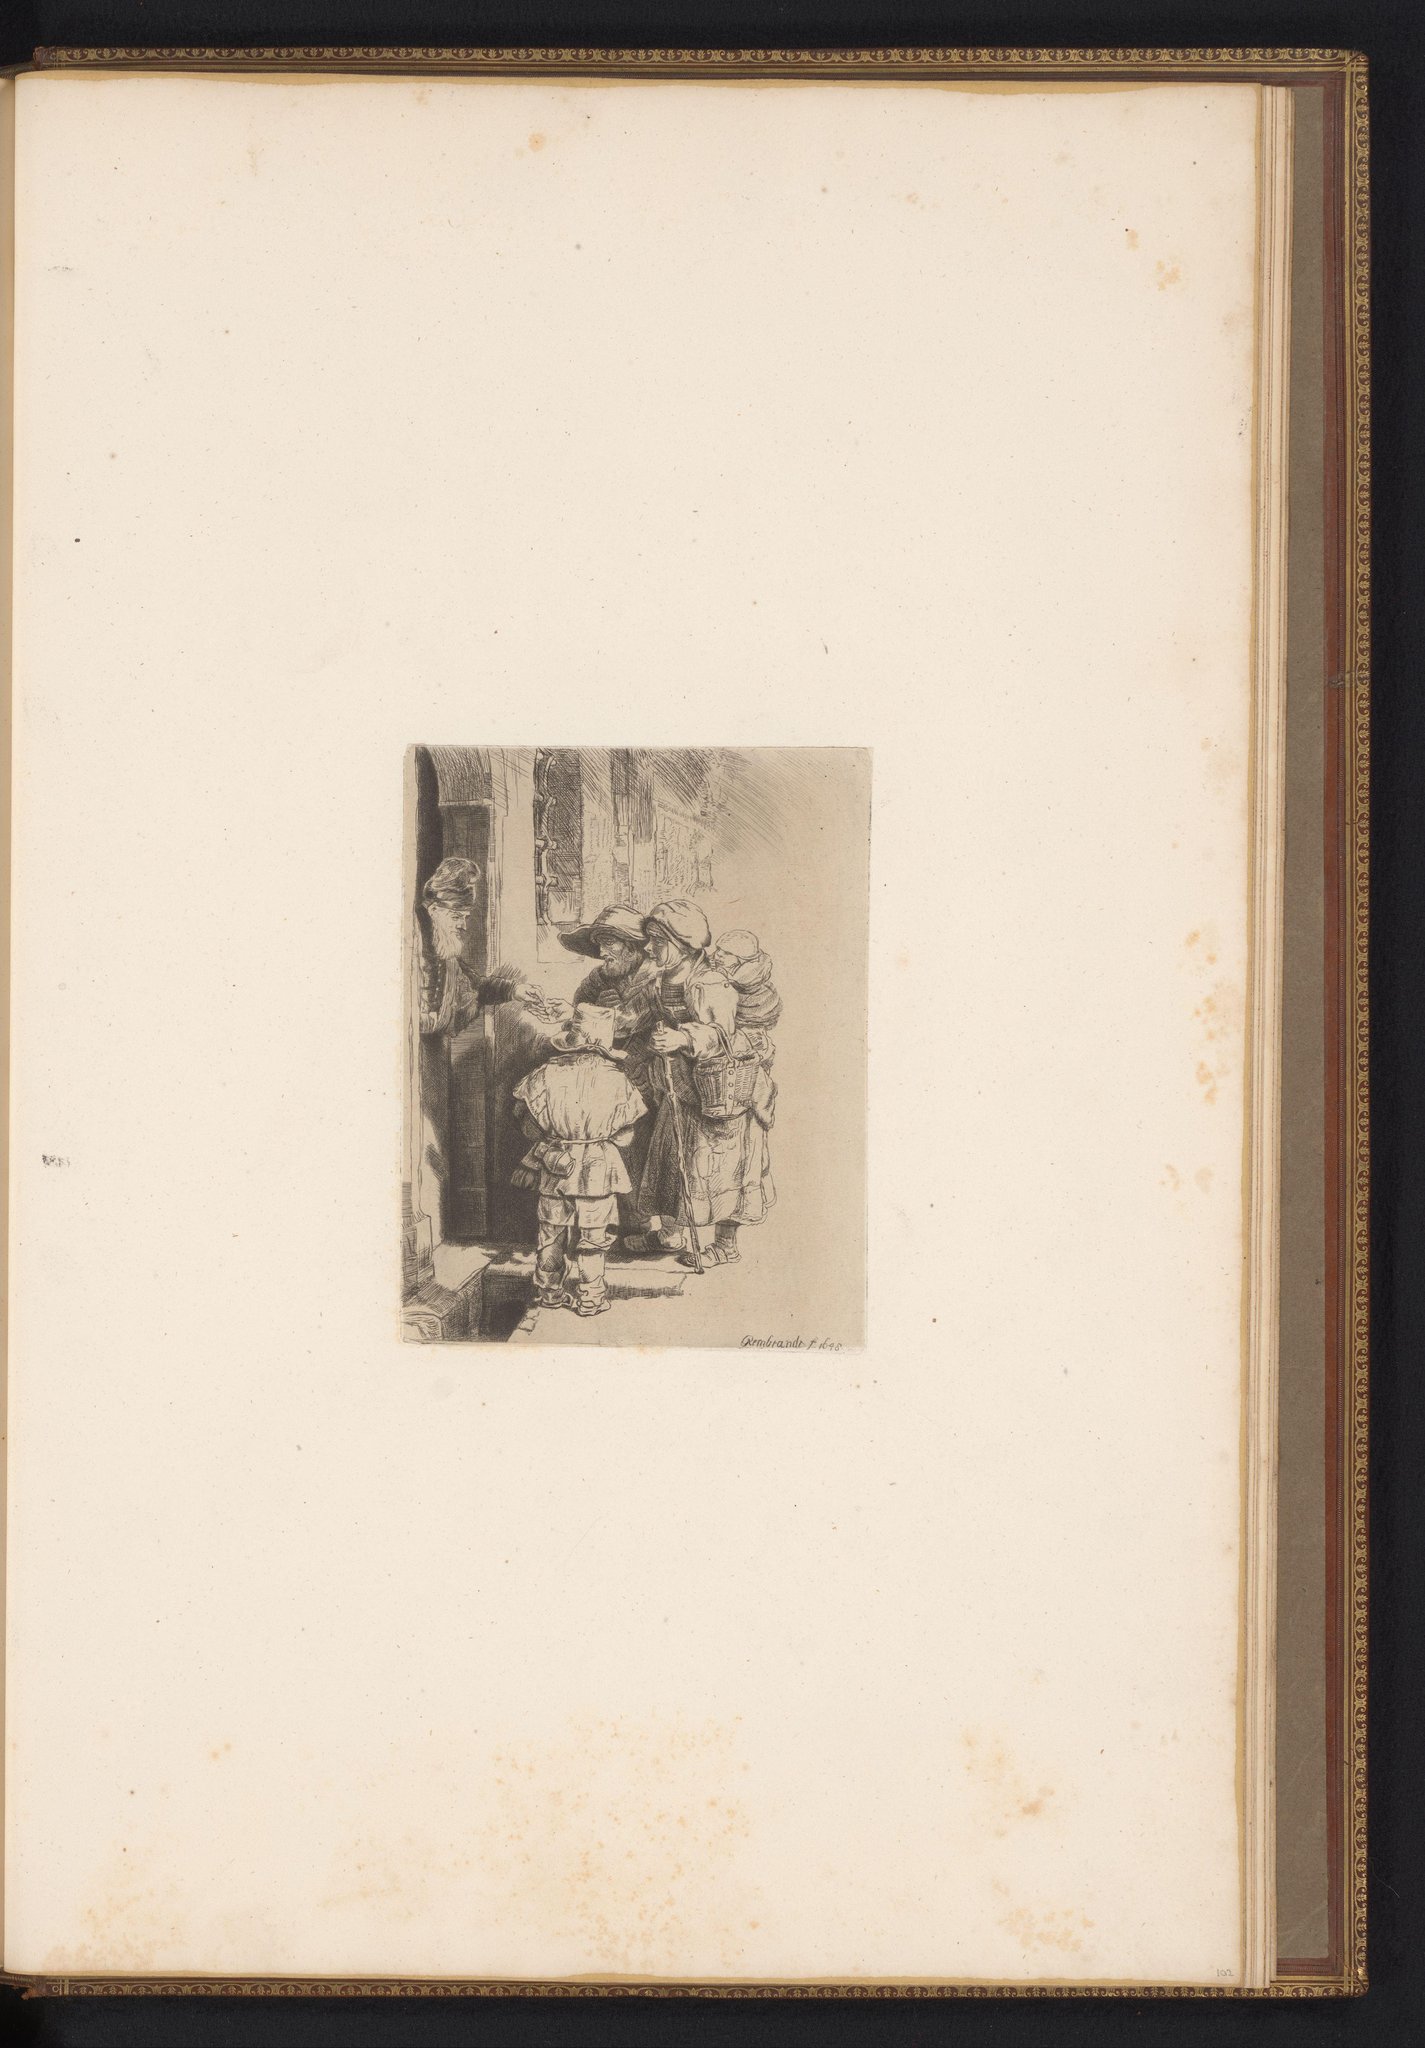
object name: album leaf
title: Een blinde draailierspeler met familie ontvangt een aalmoes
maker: william baillie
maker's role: print maker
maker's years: 1723-1810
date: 1753-1810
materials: paper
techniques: drypoint, etching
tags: beggar, giving alms; collection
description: Bedelende familie ontvangt een aalmoes aan de deur van een huis. De prent maakt deel uit van een album.